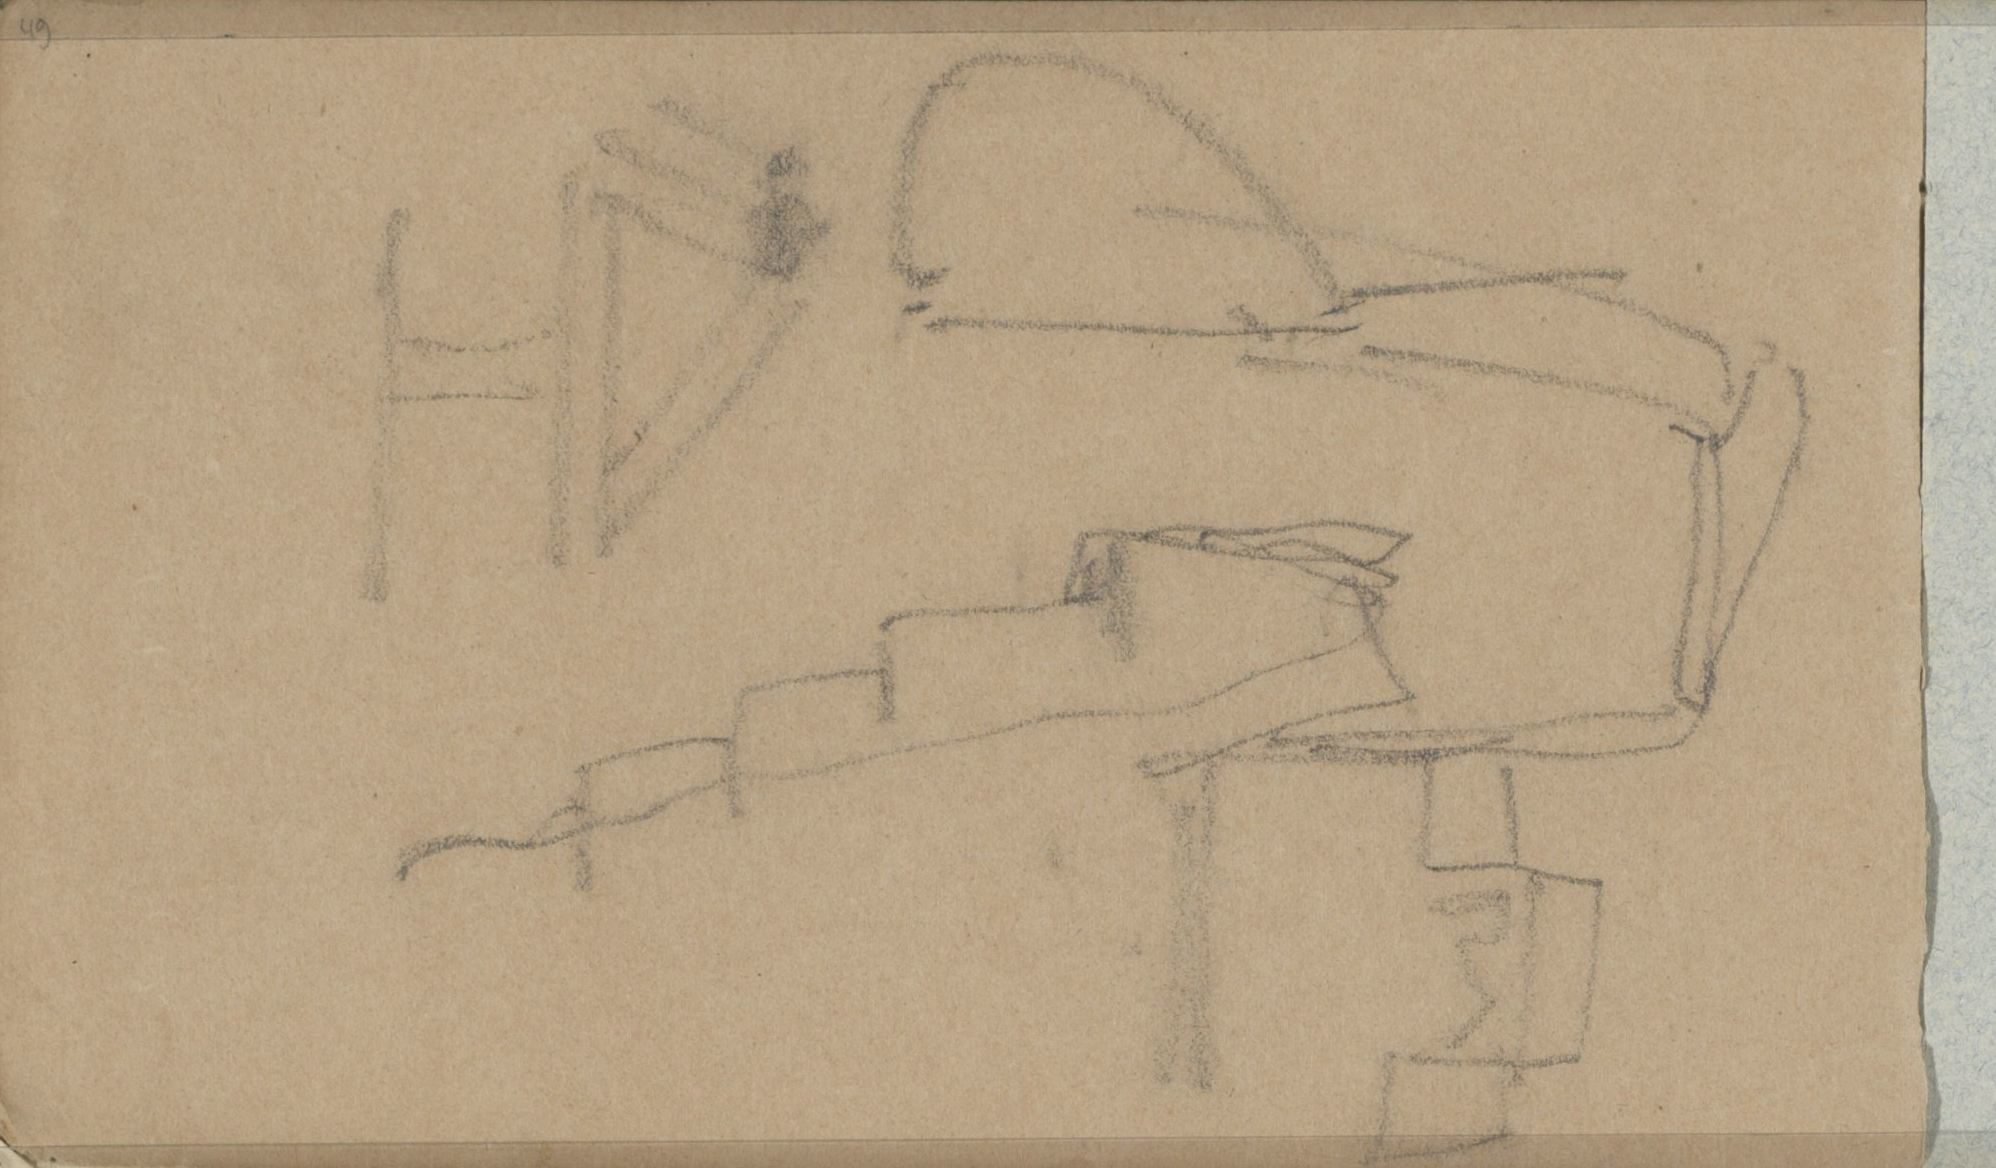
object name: sketchbook leaf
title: Studieblad, mogelijk met werktuigen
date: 1881-1883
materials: paper, pencil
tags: tools, aids, implements ~ crafts and industries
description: Pagina 49 uit een schetsboek met 30 bladen.